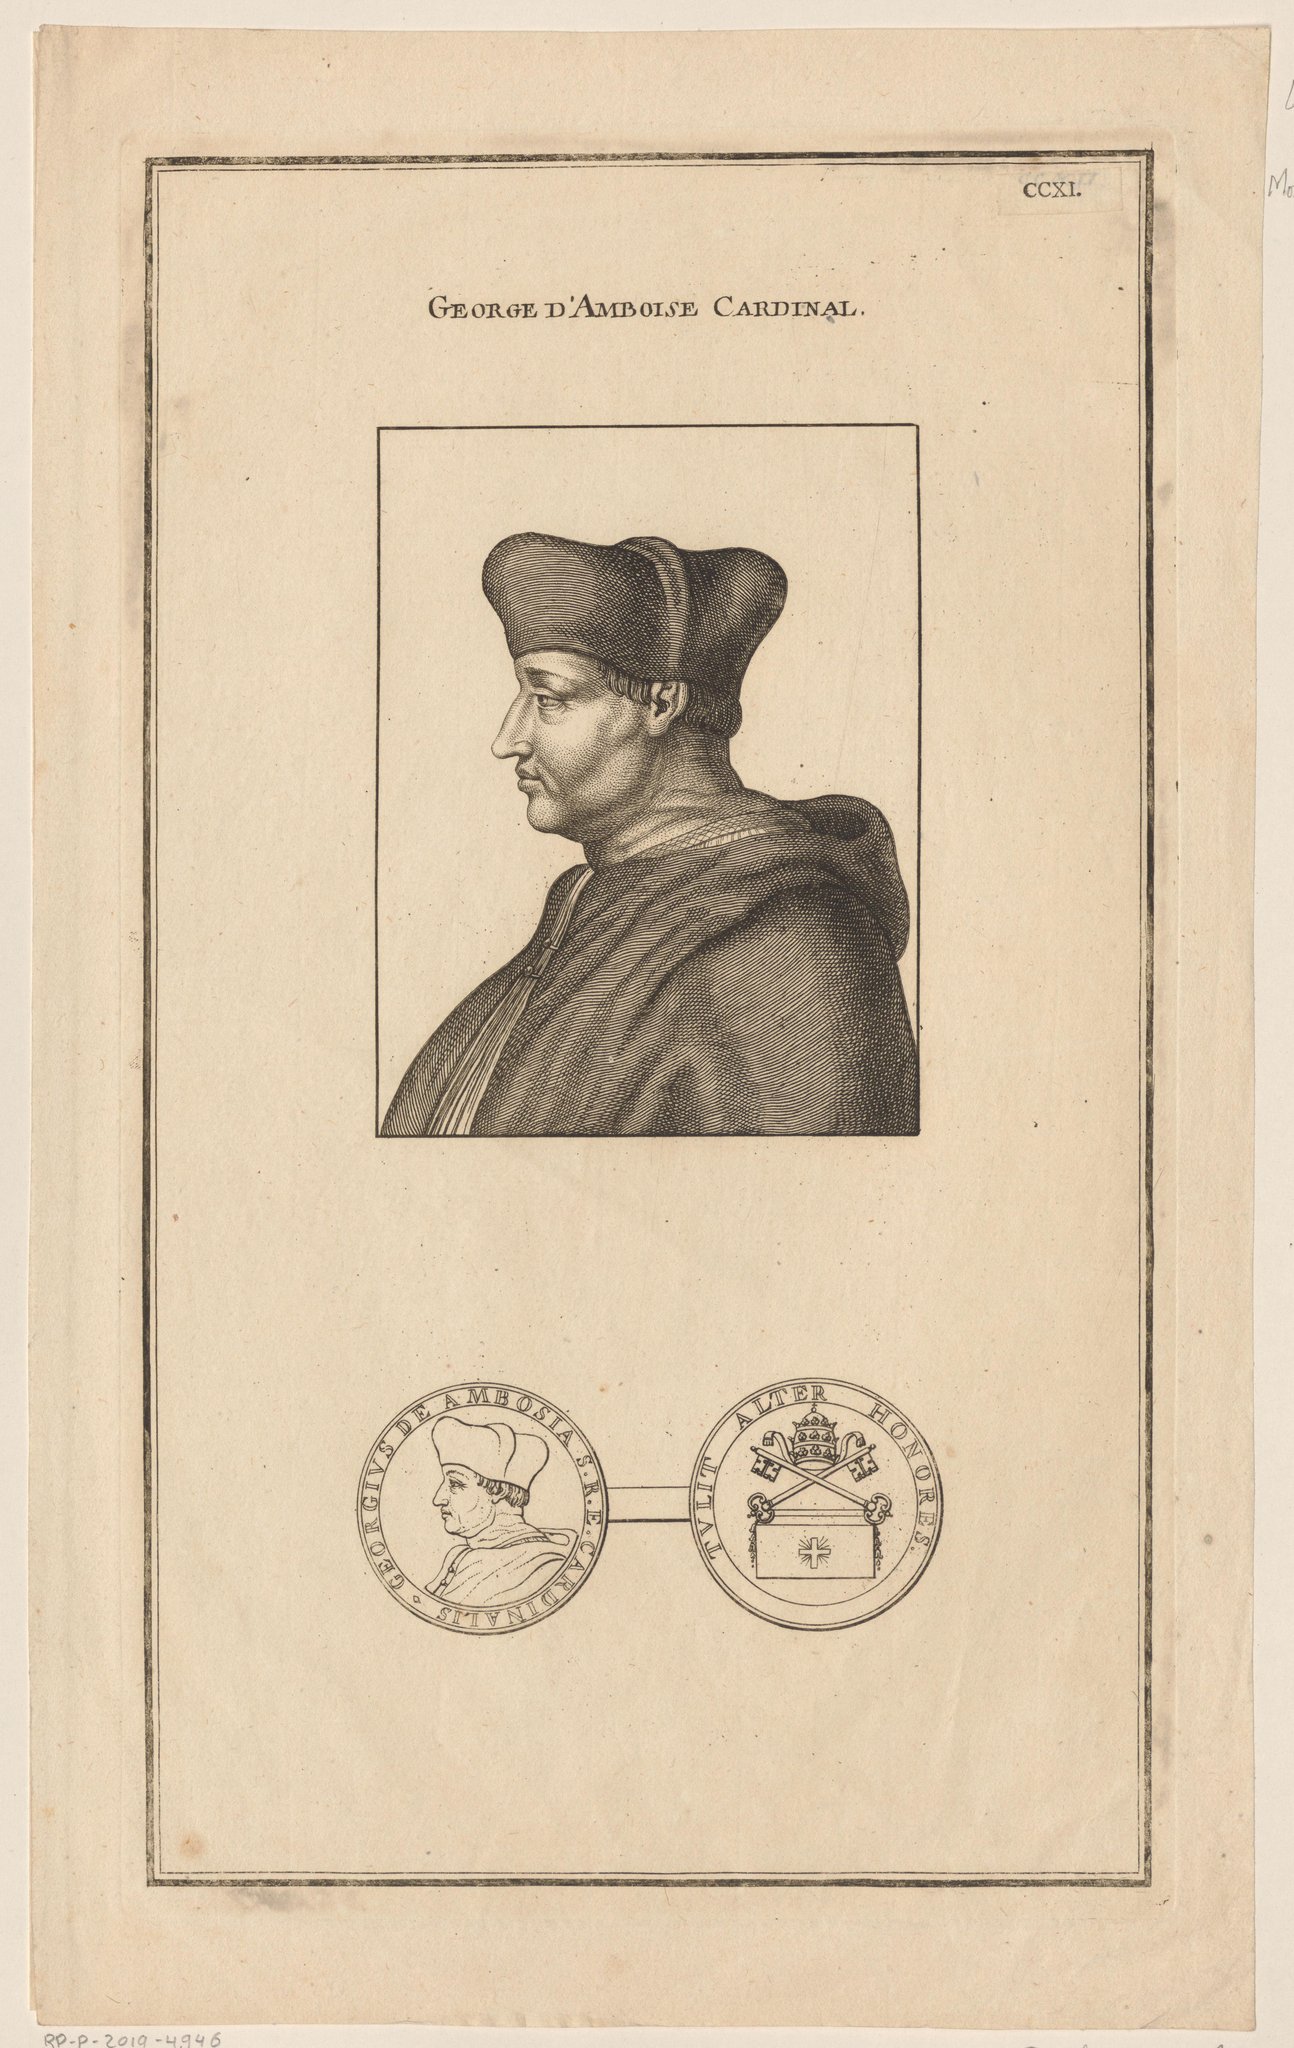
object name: print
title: Portret van Georges d'Amboise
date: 1750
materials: paper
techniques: engraving, etching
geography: london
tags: cardinal, historical persons, coin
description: Prent uit: Montfaucon, Bernard de. A collection of regal and ecclesiastical antiquities of France (...). Londen: William Innys, John en Paul Knapton, R. Manby en Henry Shute Cox, 1750, dl. 2. Prent voor het eerst, met andere nummering, verschenen in: Montfaucon, Bernard de. Les monumens de la Monarchie Françoise (...). Parijs: Julien-Michel Gandouin en Pierre-François Giffart, 1729-1733.